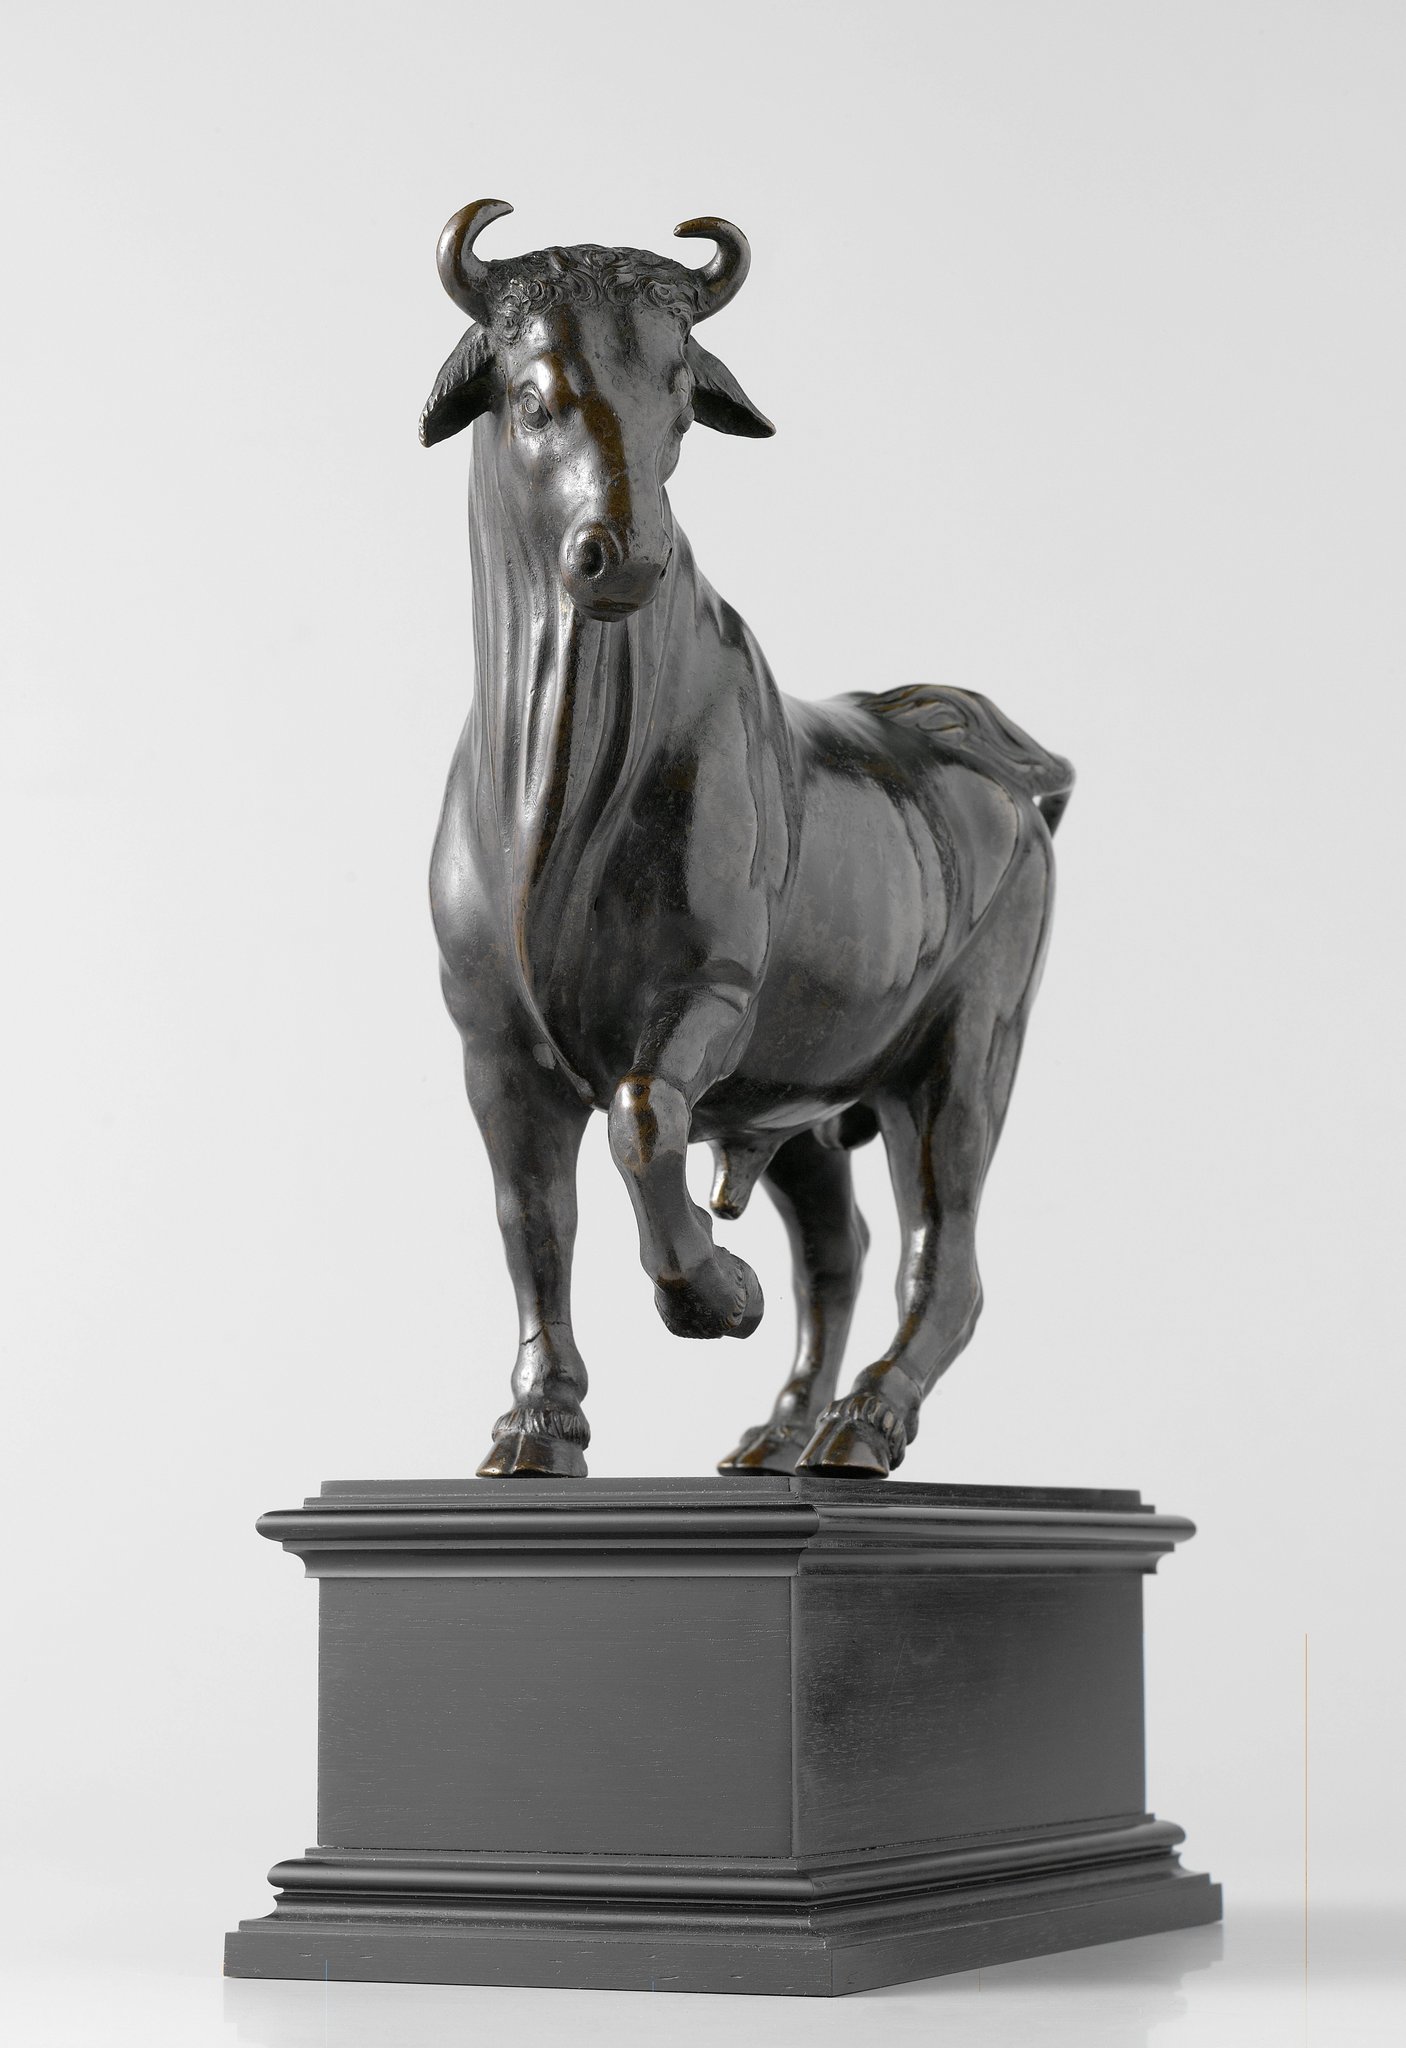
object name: figure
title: Stier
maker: giambologna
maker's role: draughtsman, goldsmith, sculptor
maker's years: 1524-1608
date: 1600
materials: bronze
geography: florence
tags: bull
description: Workshop of Giambologna (1529 - 1608). Bull. Bronze. Florence, c. 1600.